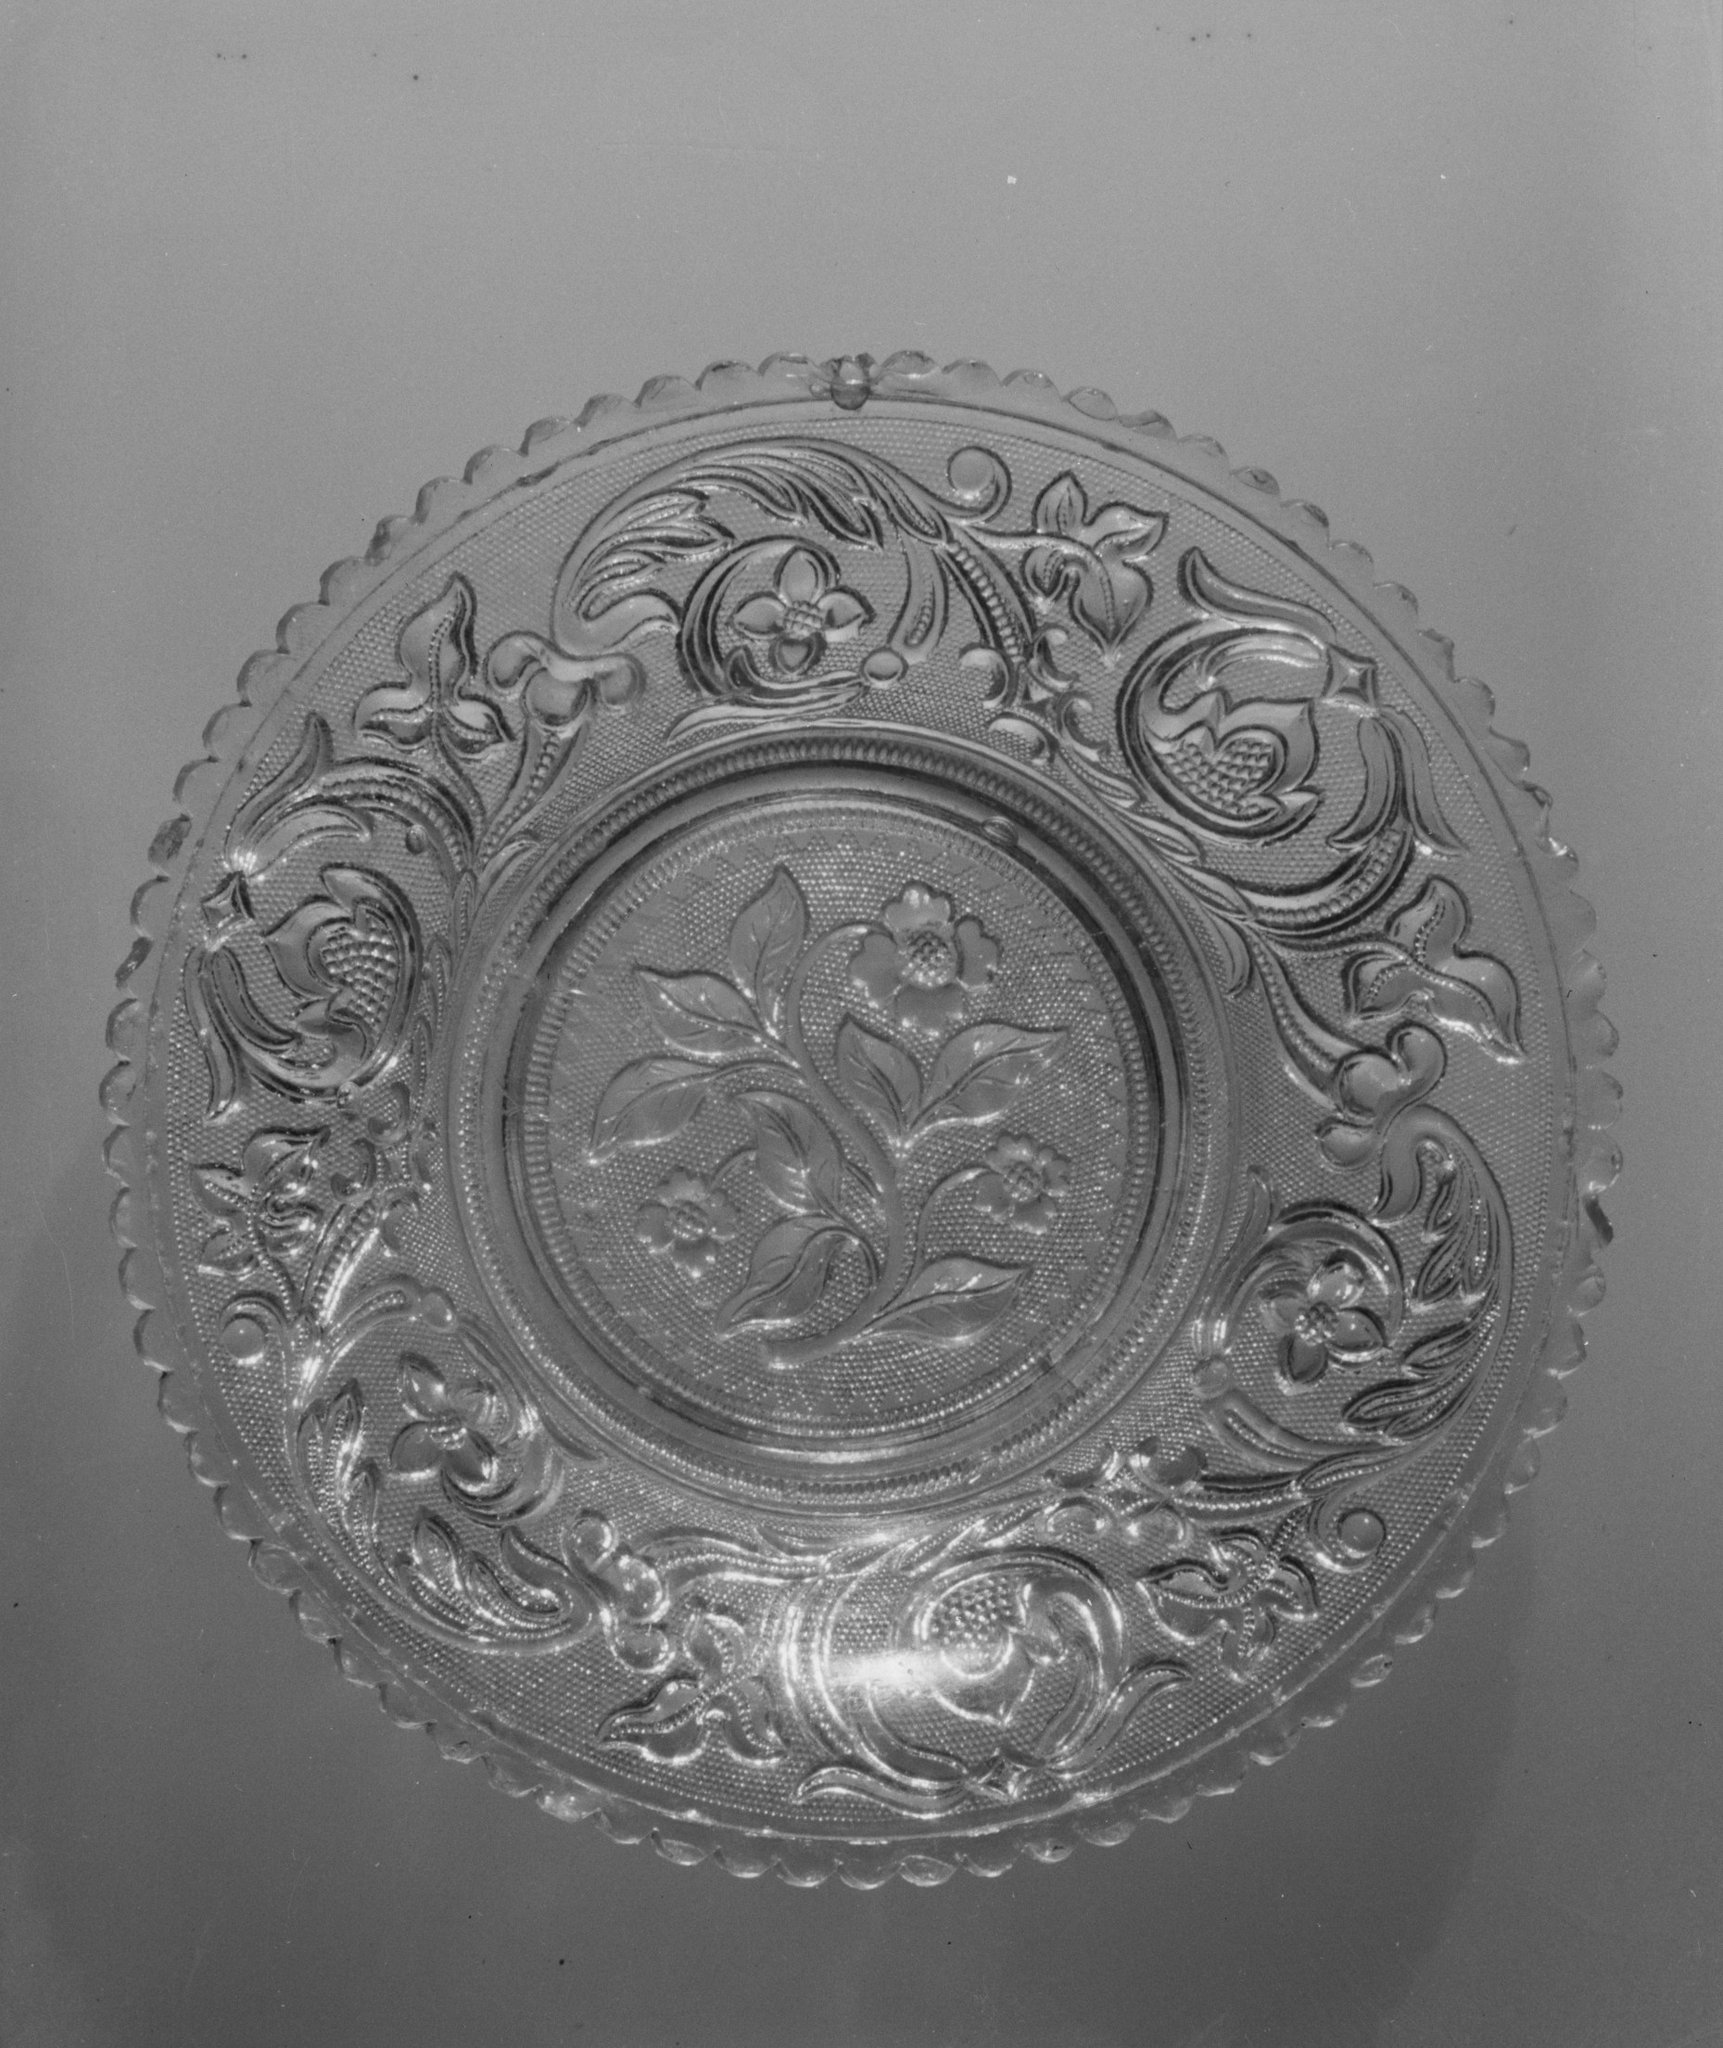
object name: bowl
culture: american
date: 1840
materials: glass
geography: united states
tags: flowers